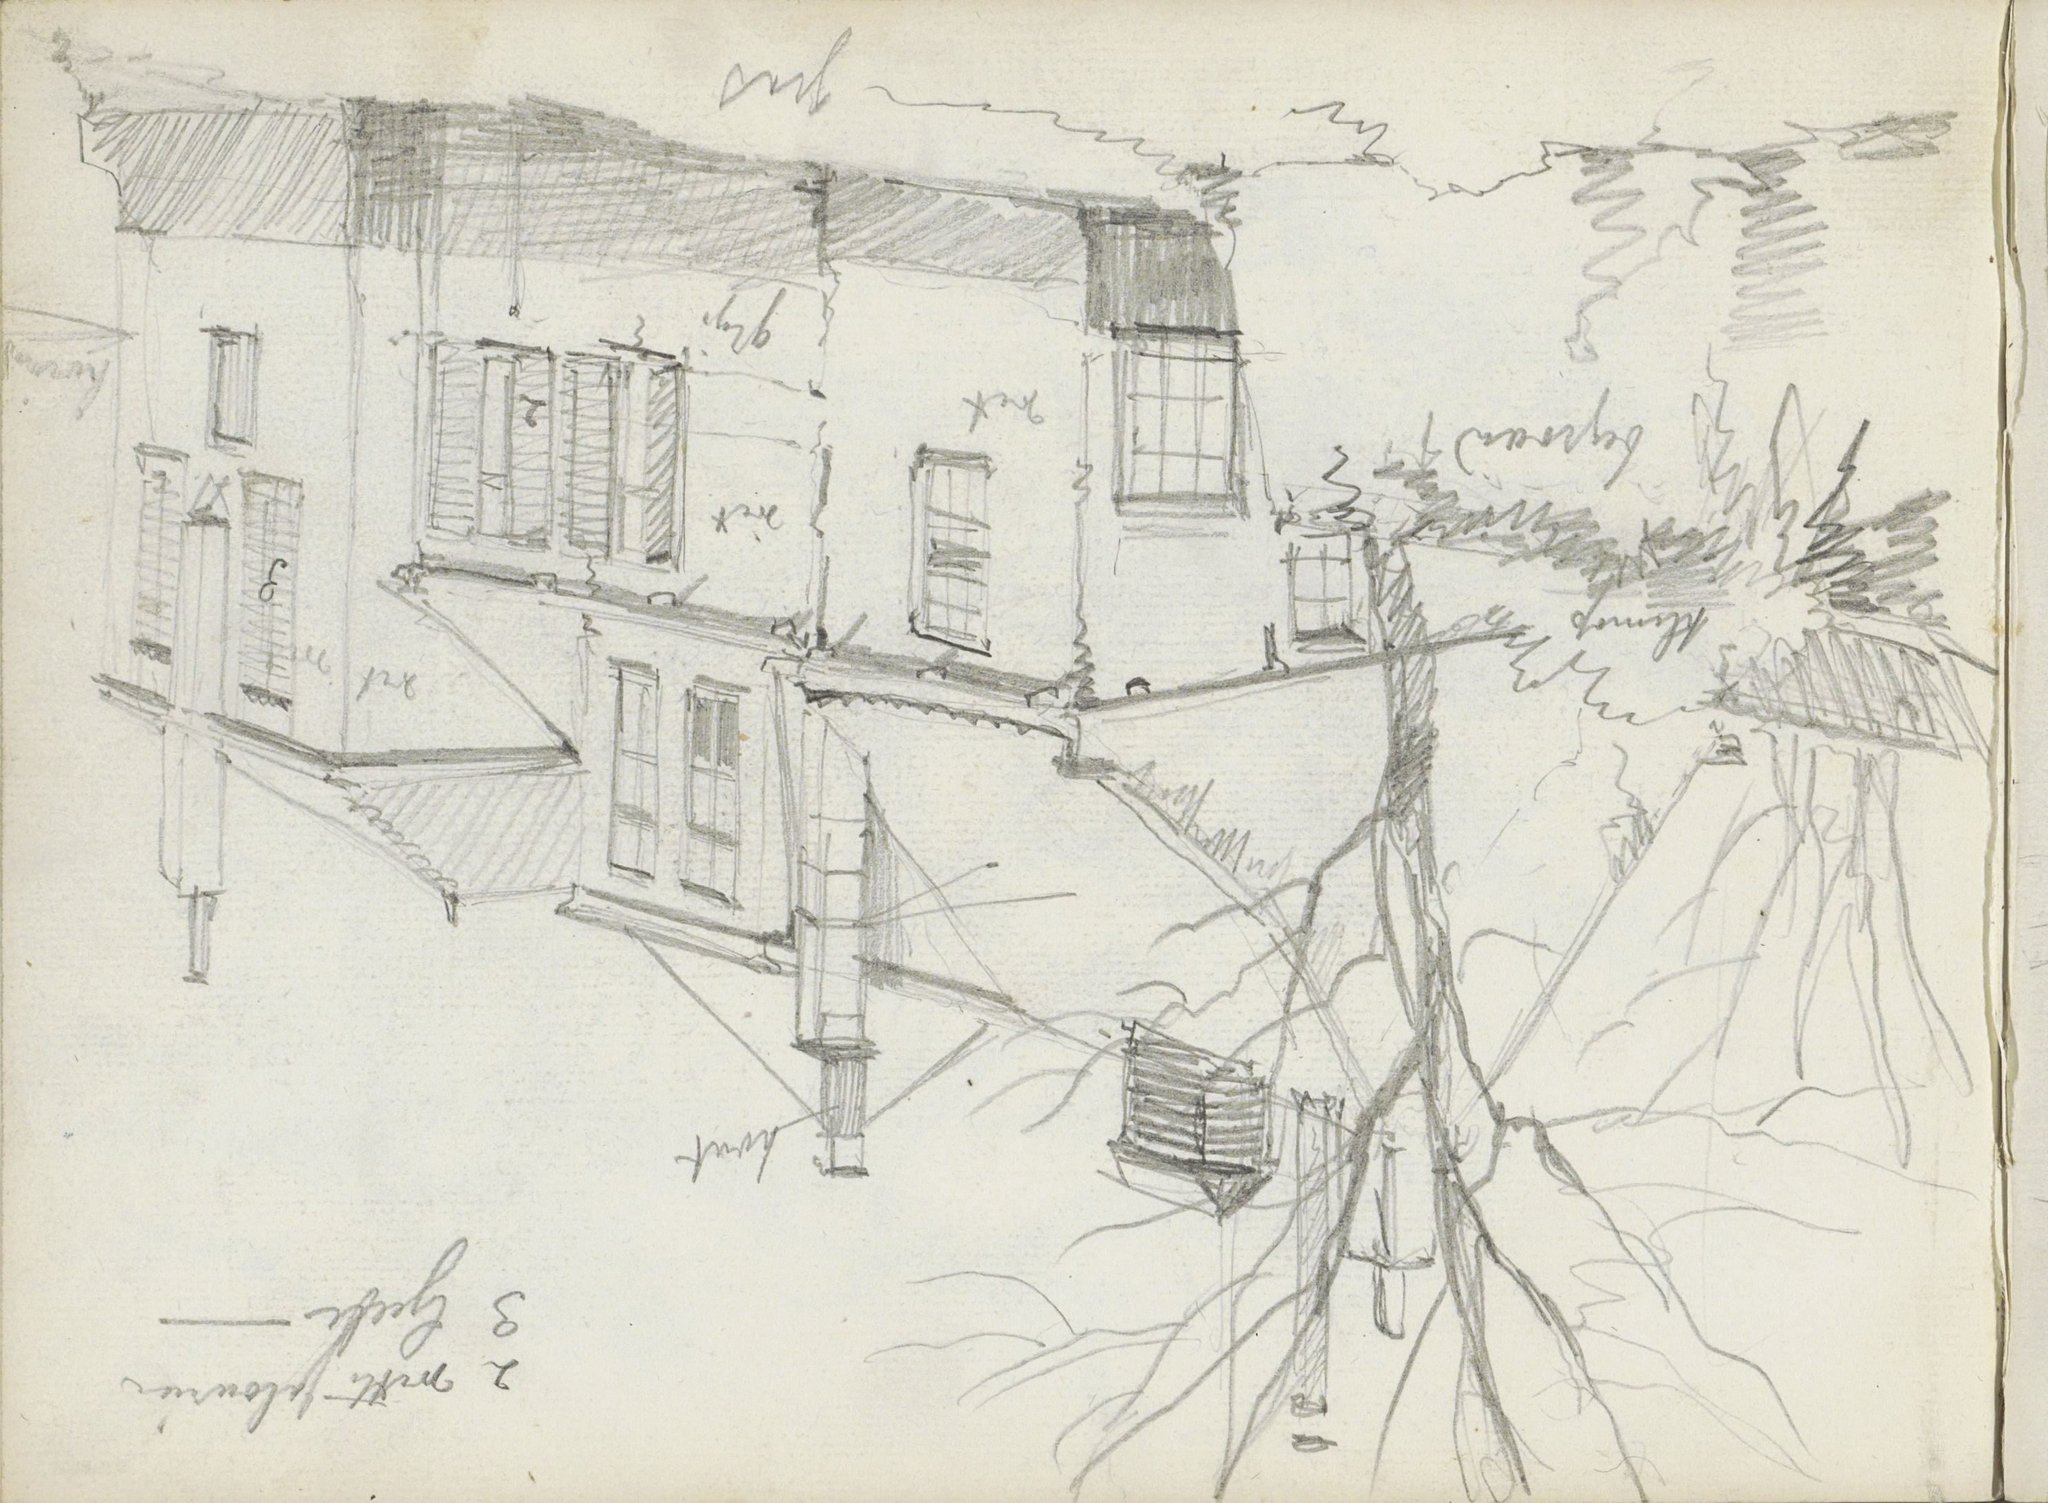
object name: sketchbook leaf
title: Huizen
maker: willem koekkoek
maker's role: draughtsman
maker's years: 1839-1895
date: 1849-1895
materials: paper, pencil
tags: the usual house or row of houses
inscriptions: kleurnotitie, handgeschreven in potlood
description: Pagina 21 verso uit een schetsboek met 26 bladen.